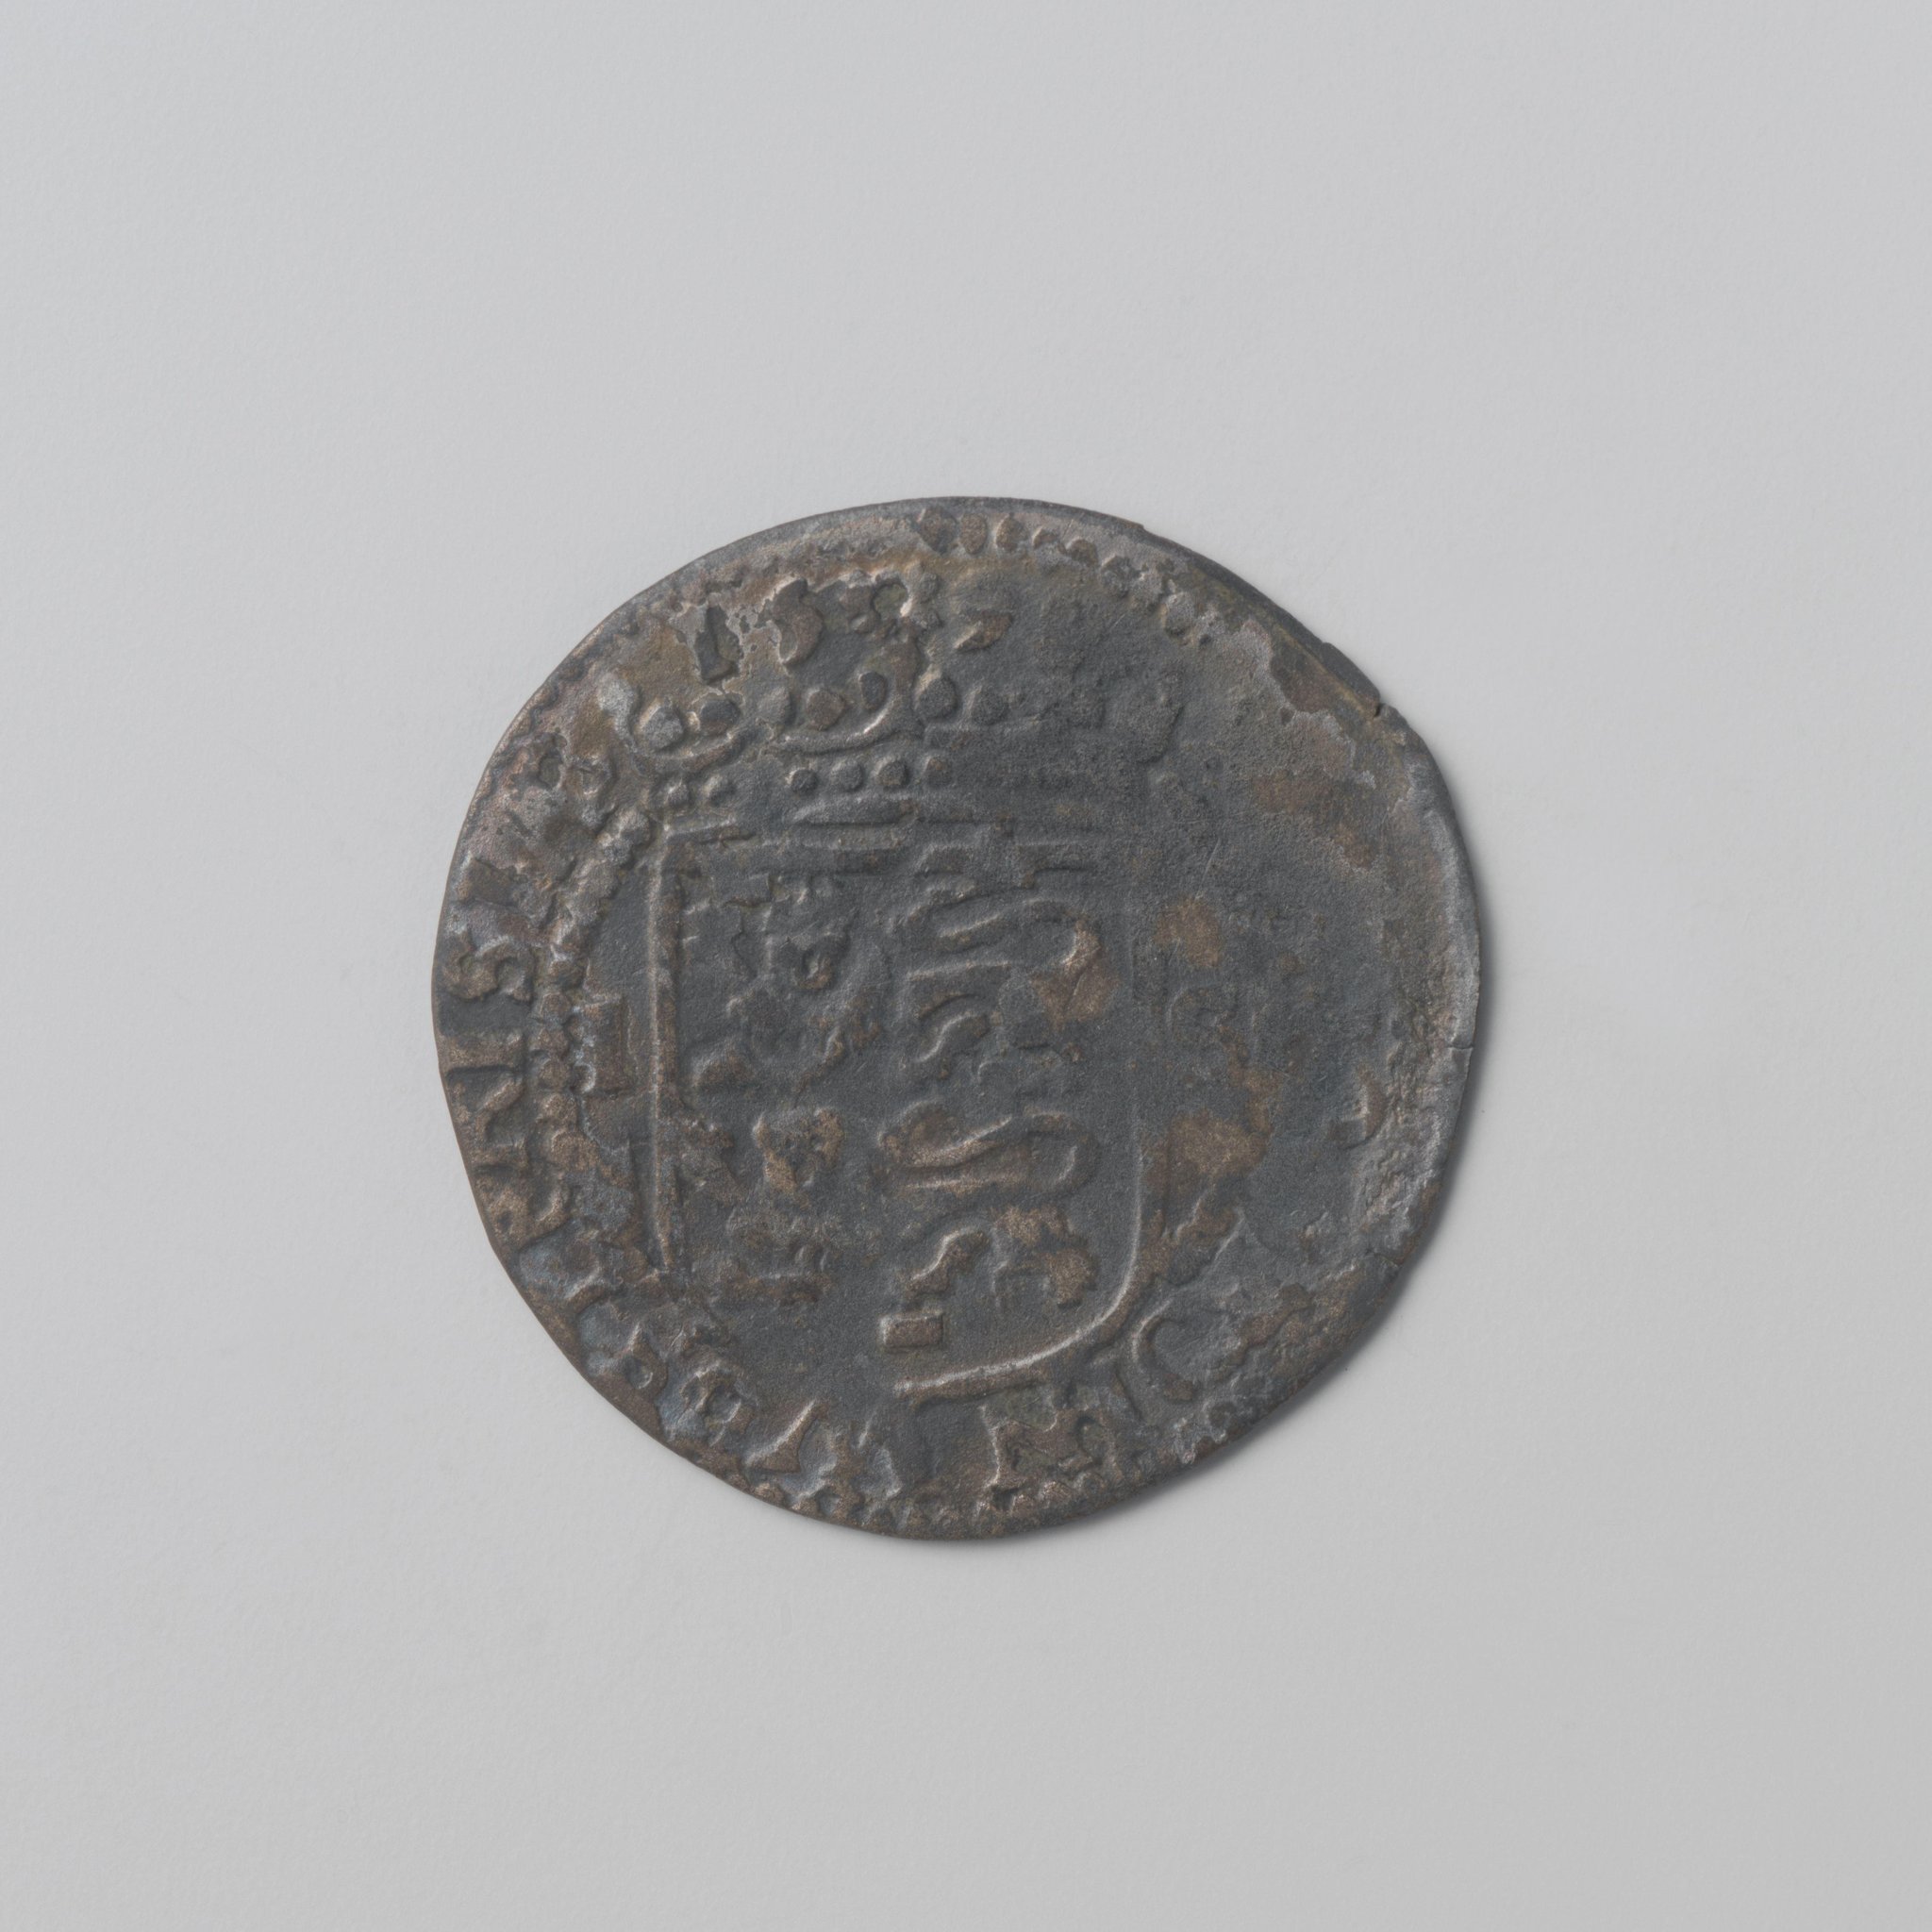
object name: coin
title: Westfriese stuiver, 1598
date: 1598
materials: silver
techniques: striking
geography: west frisia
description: Voorzijde: tussen waarde-aanduiding gekroond wapenschild van West-Friesland. Jaartal boven kroon. Keerzijde: op vierpas lang versierd kruis., in het hart letters WF.